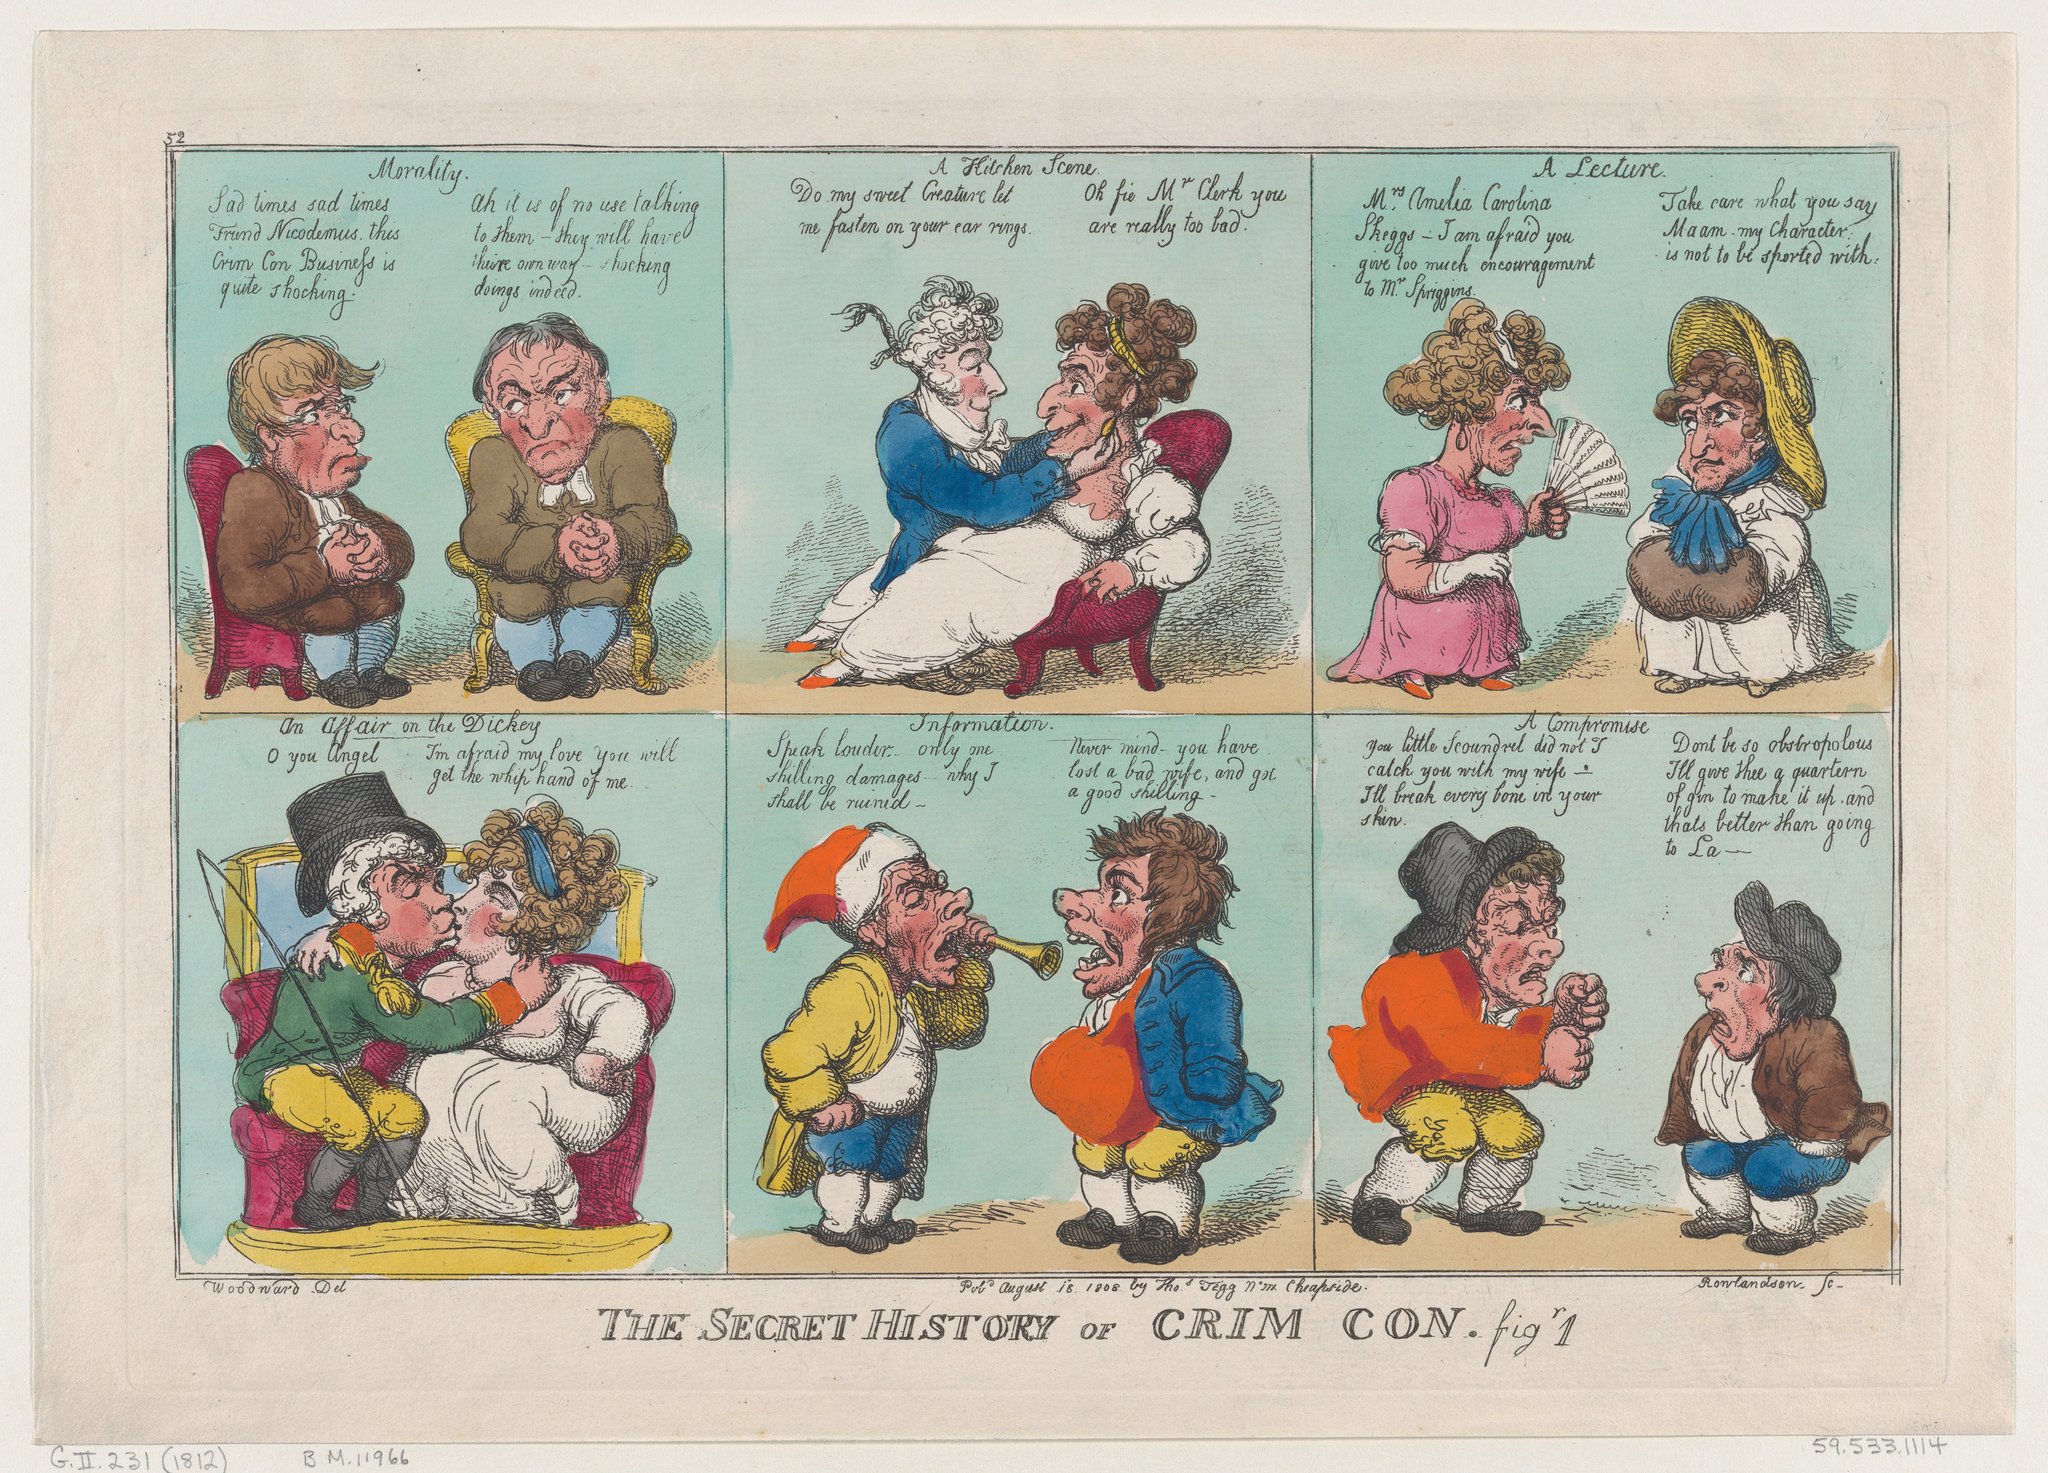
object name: print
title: The Secret History of Crim Con, Fig 1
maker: thomas rowlandson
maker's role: artist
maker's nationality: british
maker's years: 1757-1827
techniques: etching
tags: satire,men,women